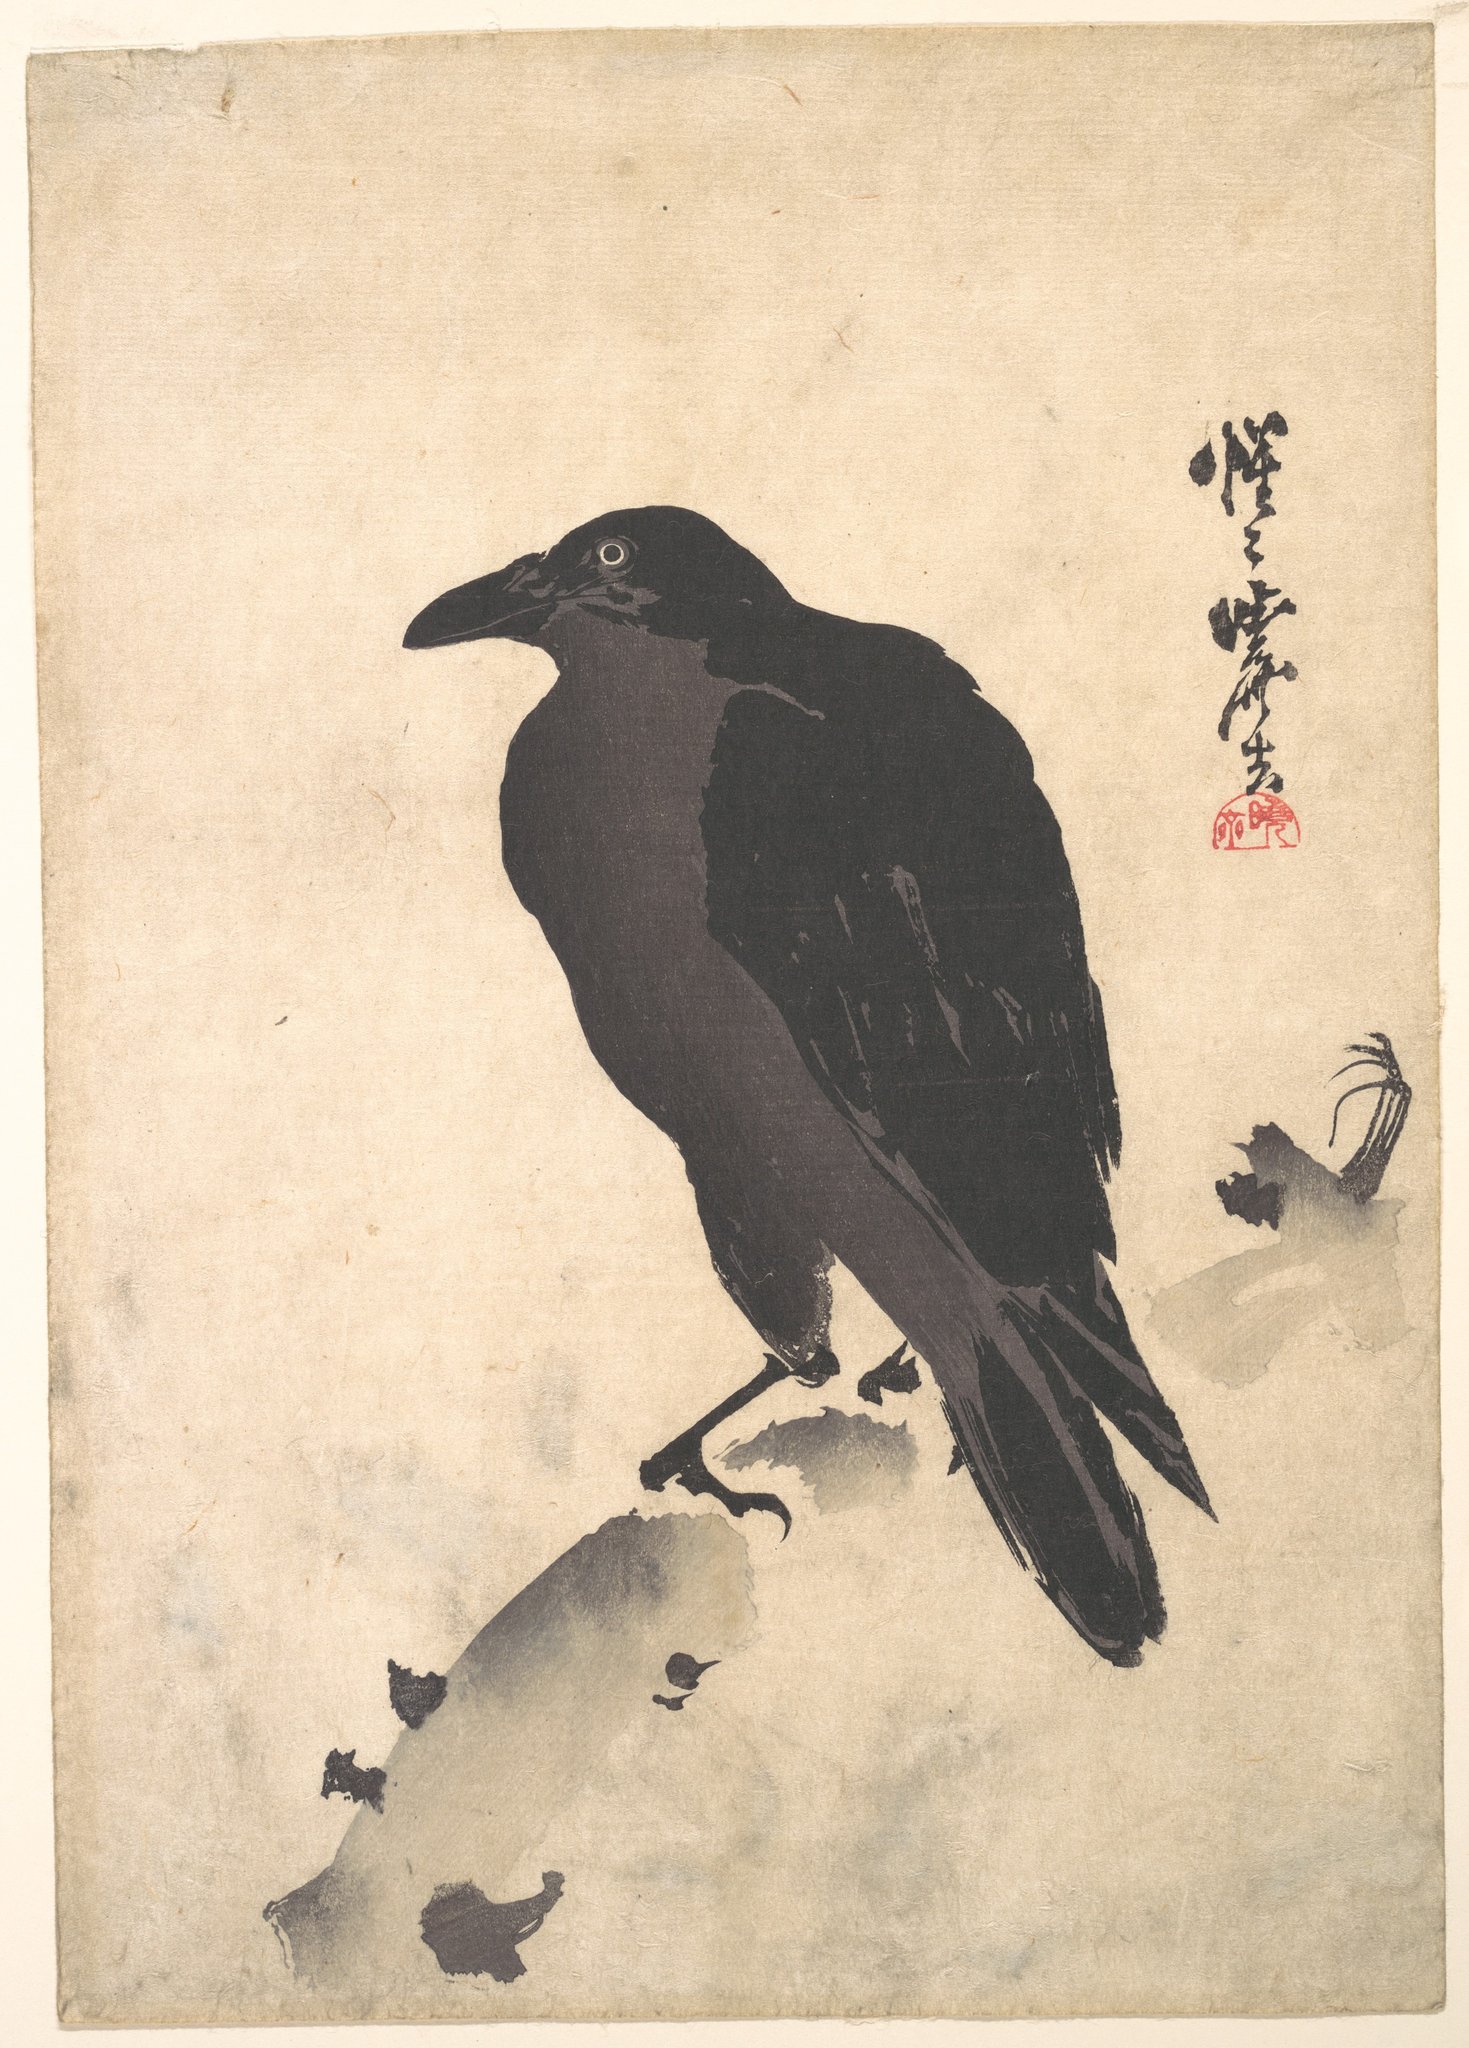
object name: print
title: Crow Resting on Wood Trunk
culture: japanese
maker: kawanabe kyōsai 河鍋暁斎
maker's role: artist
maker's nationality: japanese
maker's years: 1831-1889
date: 1831-1899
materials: ink, paper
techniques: woodblock print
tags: birds